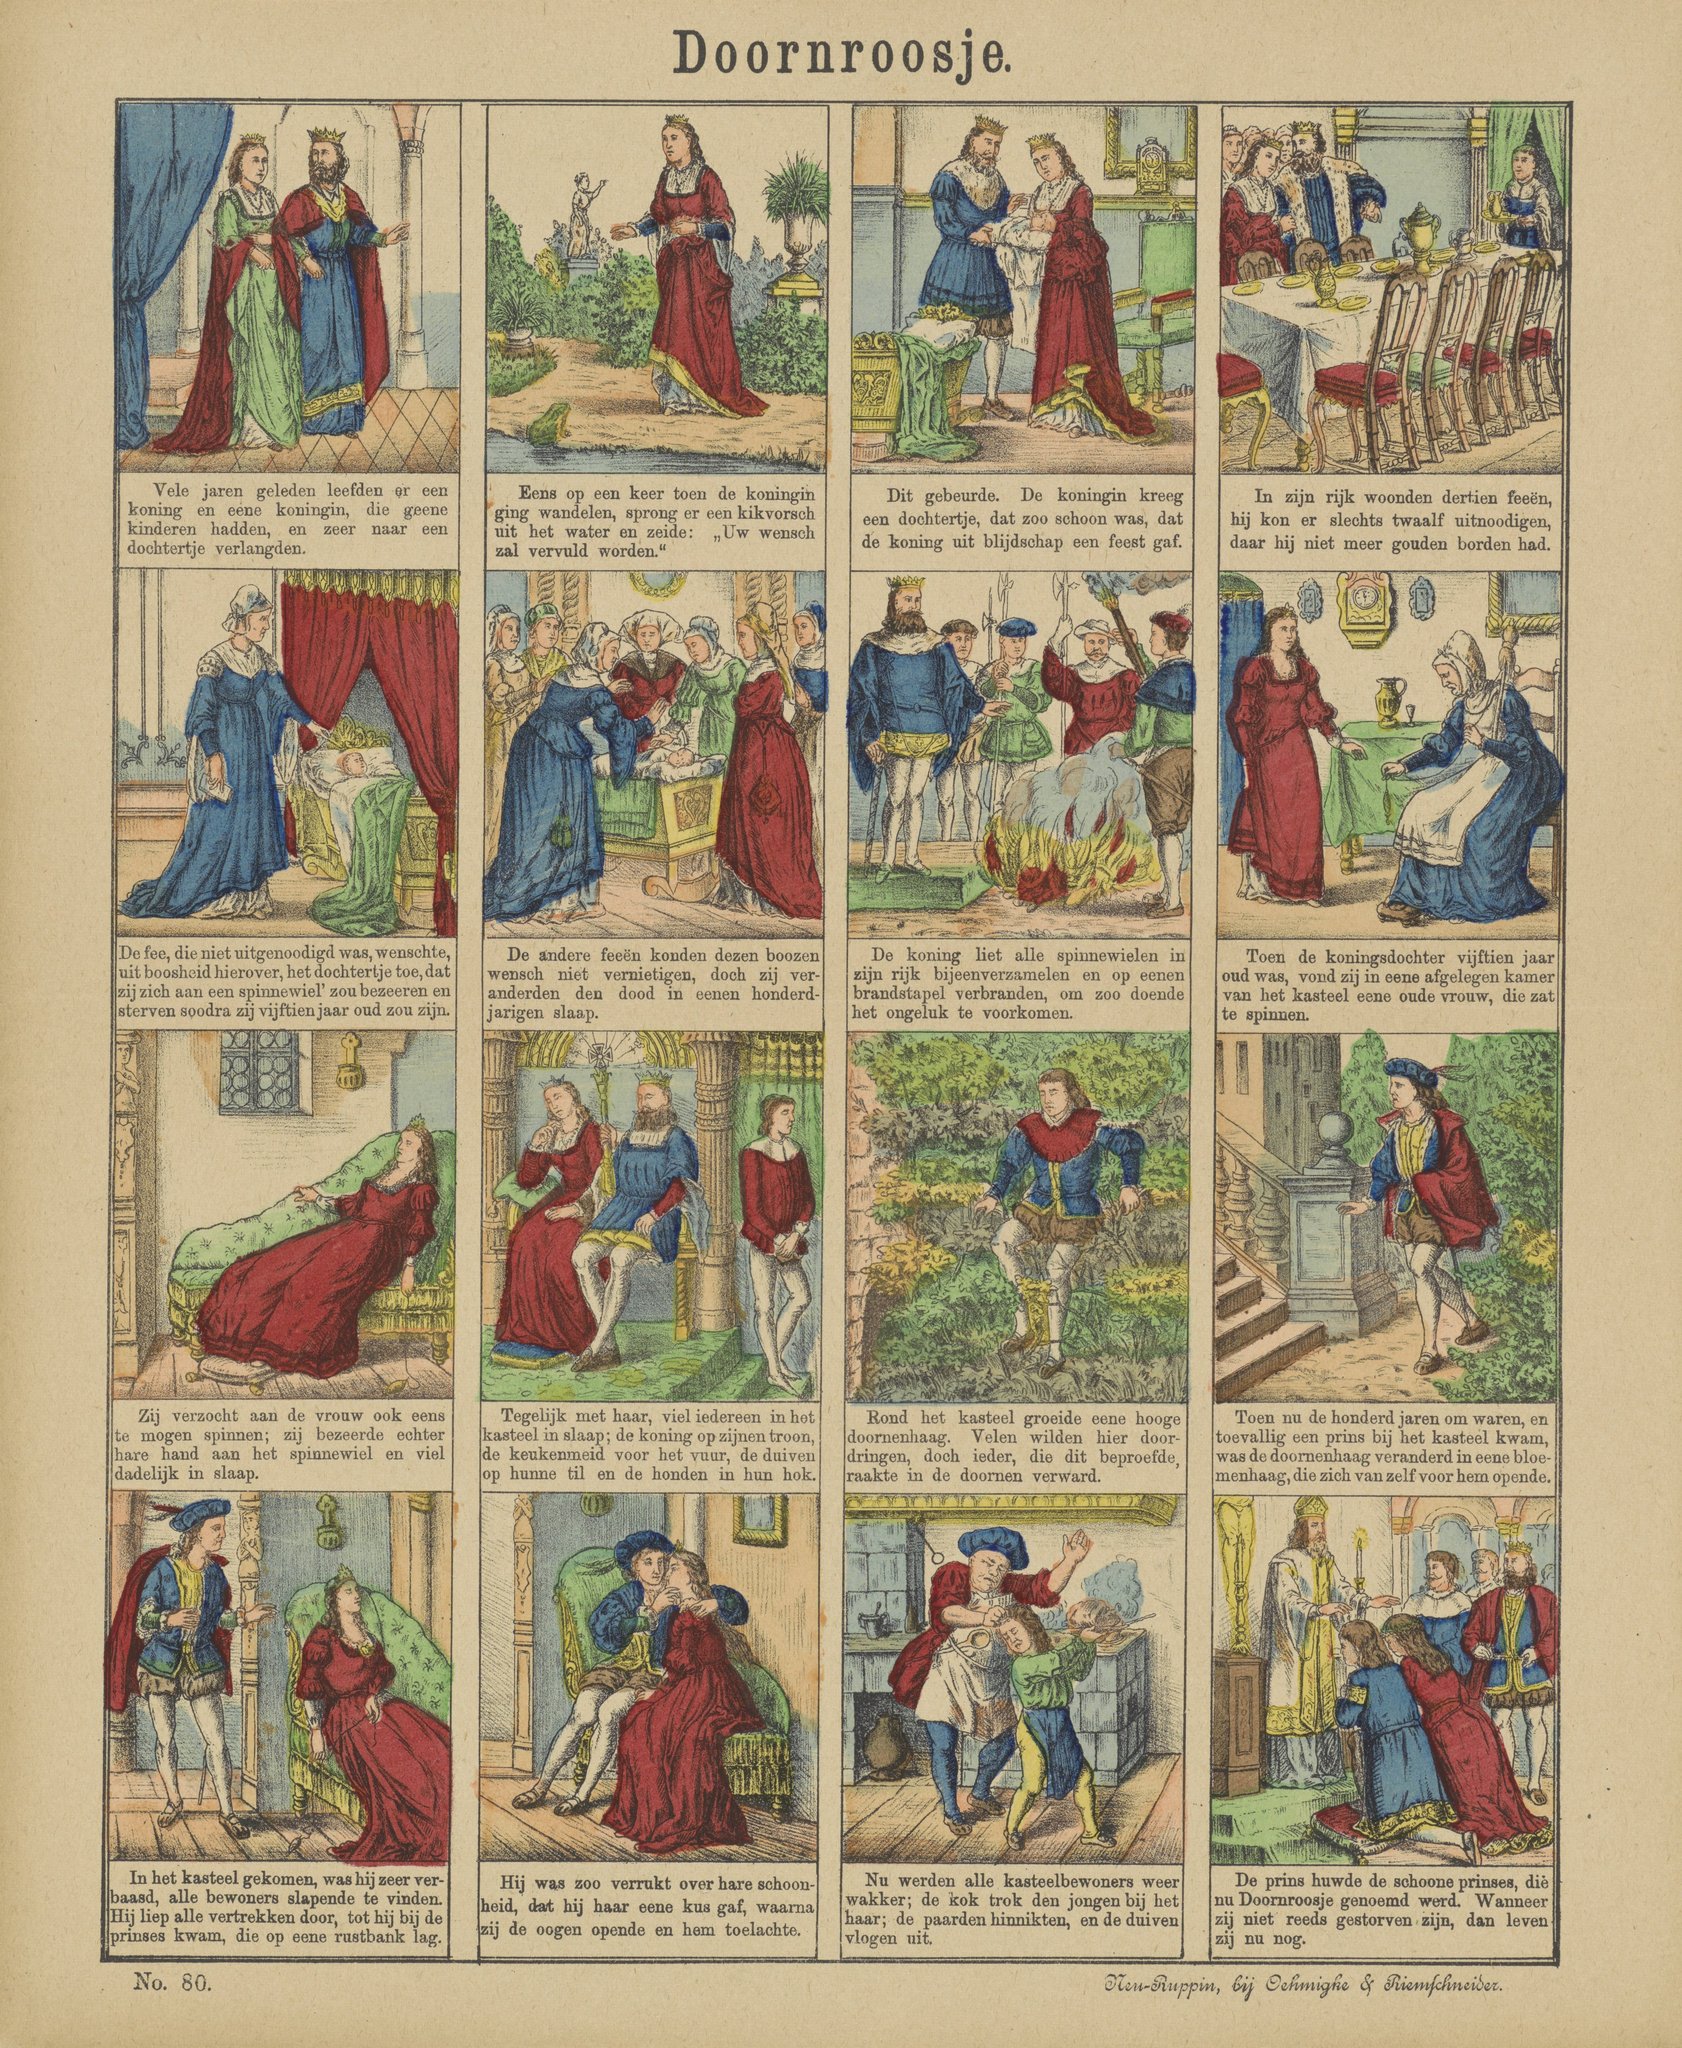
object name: popular print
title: Doornroosje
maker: Anonymous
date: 1828-1937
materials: paper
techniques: hand coloring, letterpress printing, lithograph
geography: neuruppin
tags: tales and fairy tales: sleeping beauty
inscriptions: collector's mark: Lugt 2760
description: Blad met 16 voorstellingen uit het sprookje van Doornroosje. Onder elke afbeelding een onderschrift. Genummerd linksonder: No. 80.